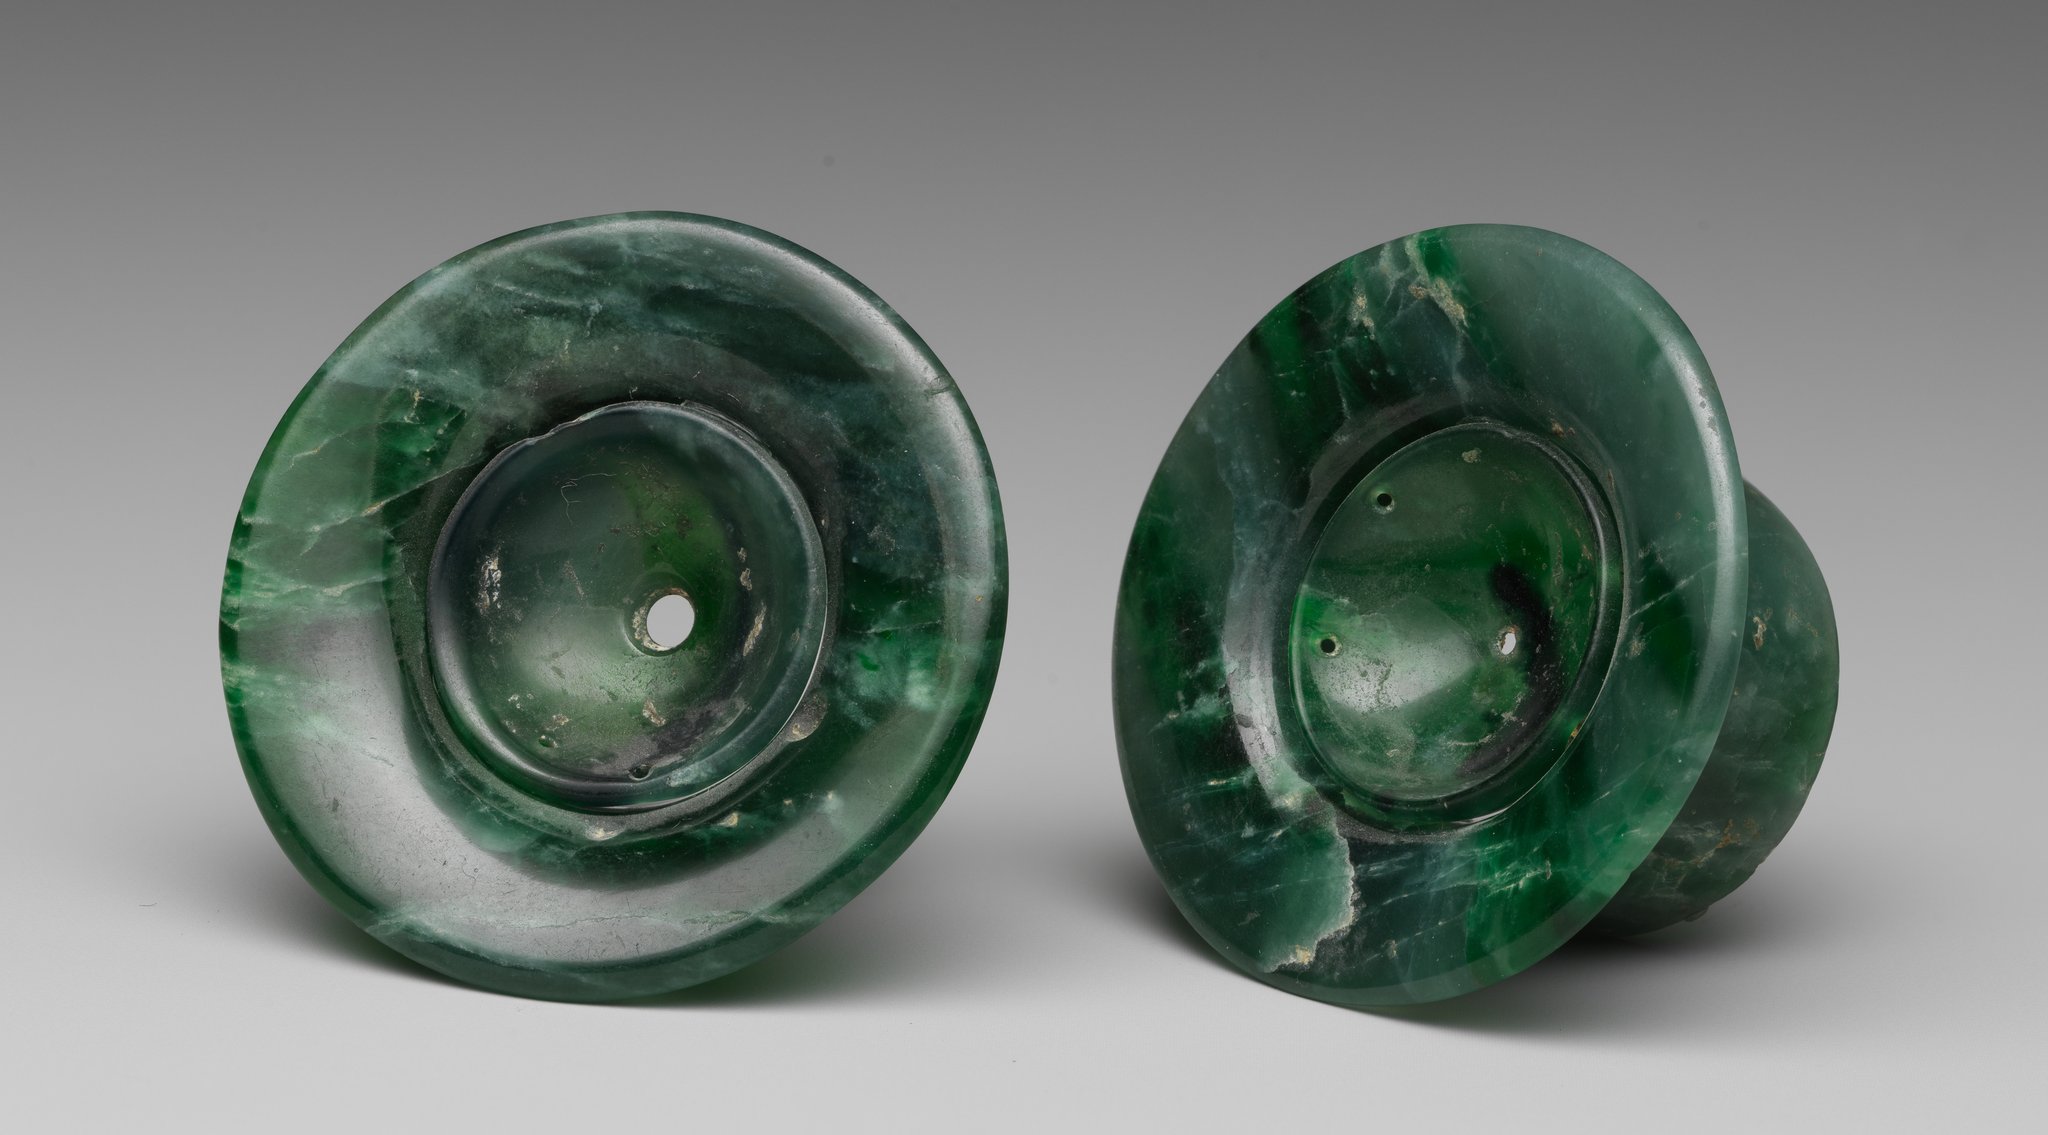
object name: pair of earflares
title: Earflares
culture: olmec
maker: olmec artist(s)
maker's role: artist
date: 900-400 BCE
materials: jade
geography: mexico